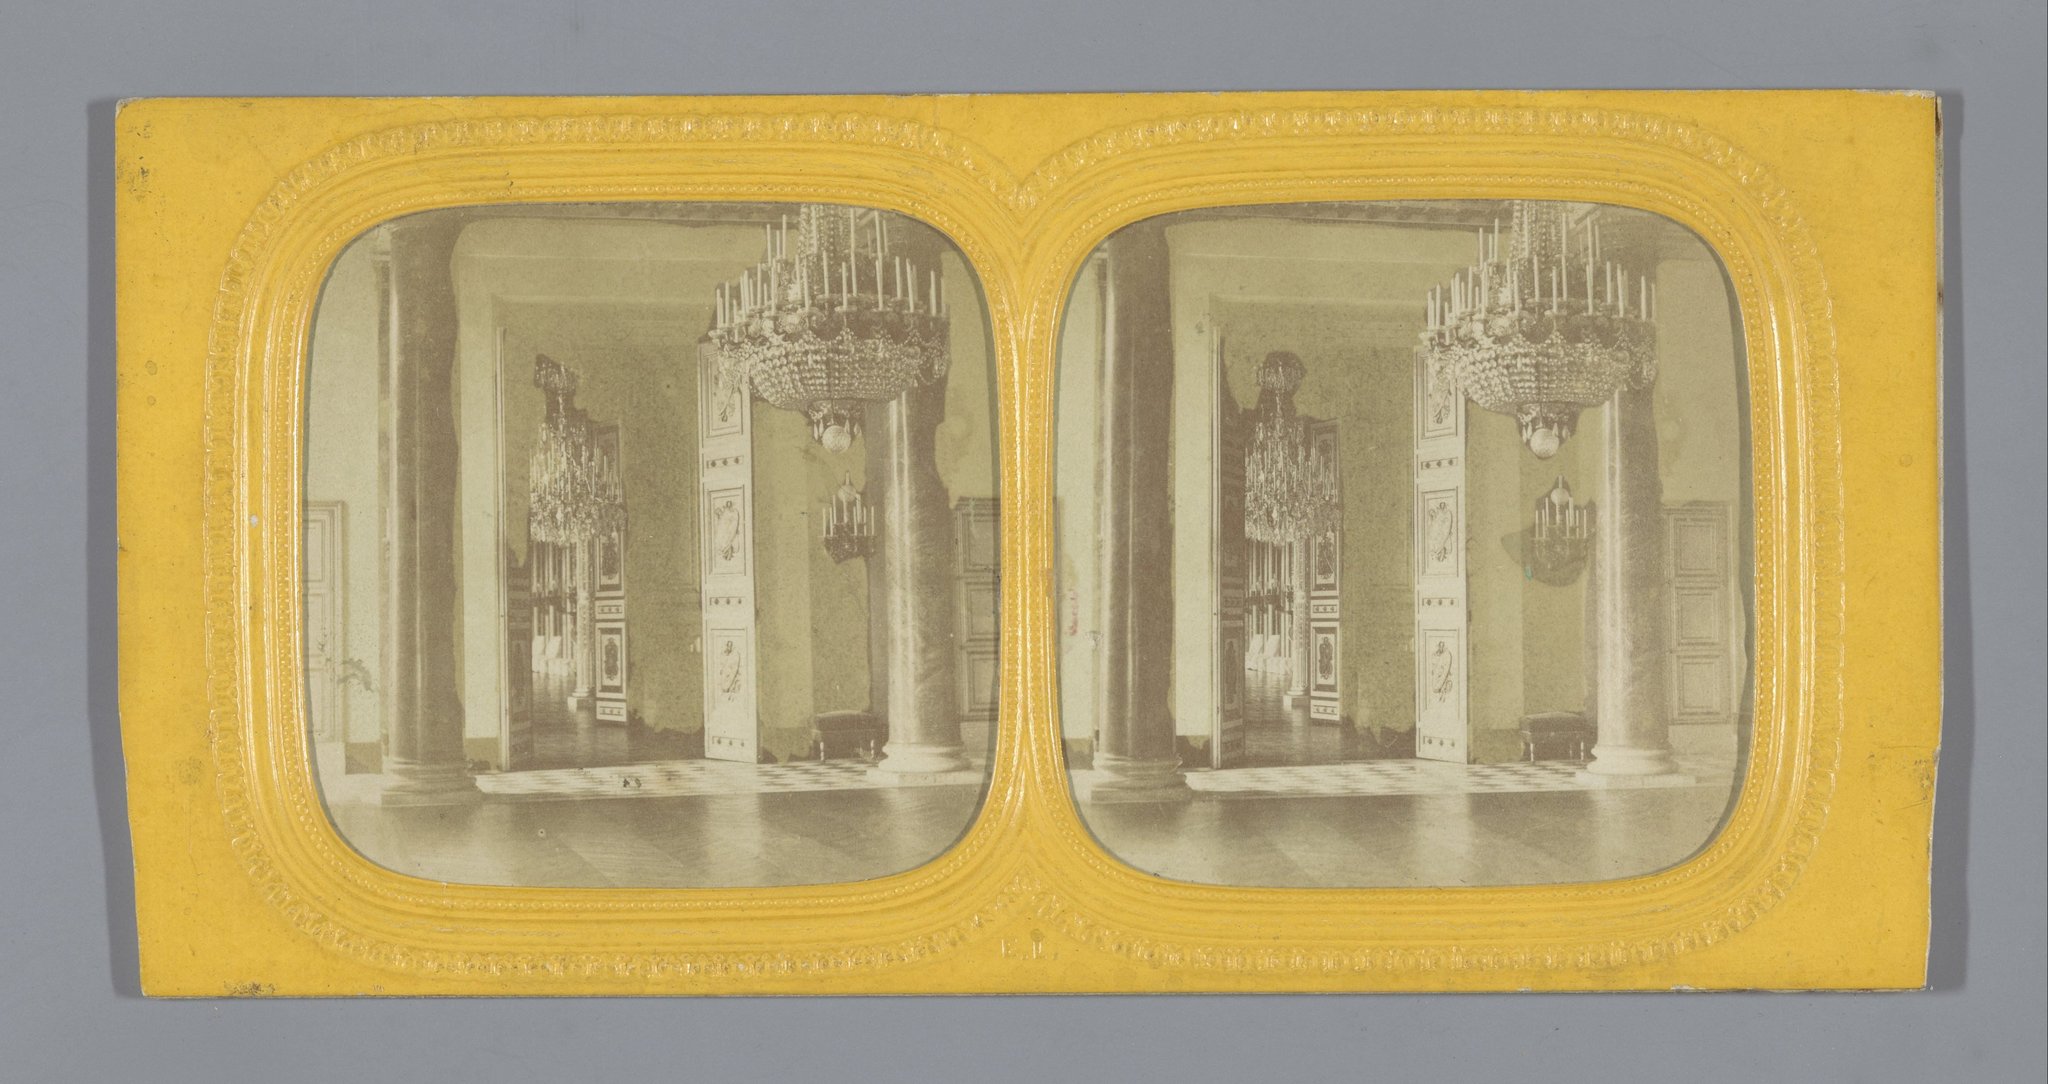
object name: tissue stereograph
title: Wachterszaal in het Tuilerieënpaleis, Parijs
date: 1855-1875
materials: cardboard, paper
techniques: albumen print, hand coloring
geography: paris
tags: palace - aa - civic architecture: inside, tuileries palace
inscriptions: inscription: ‘met entrée salon/ de la paix’